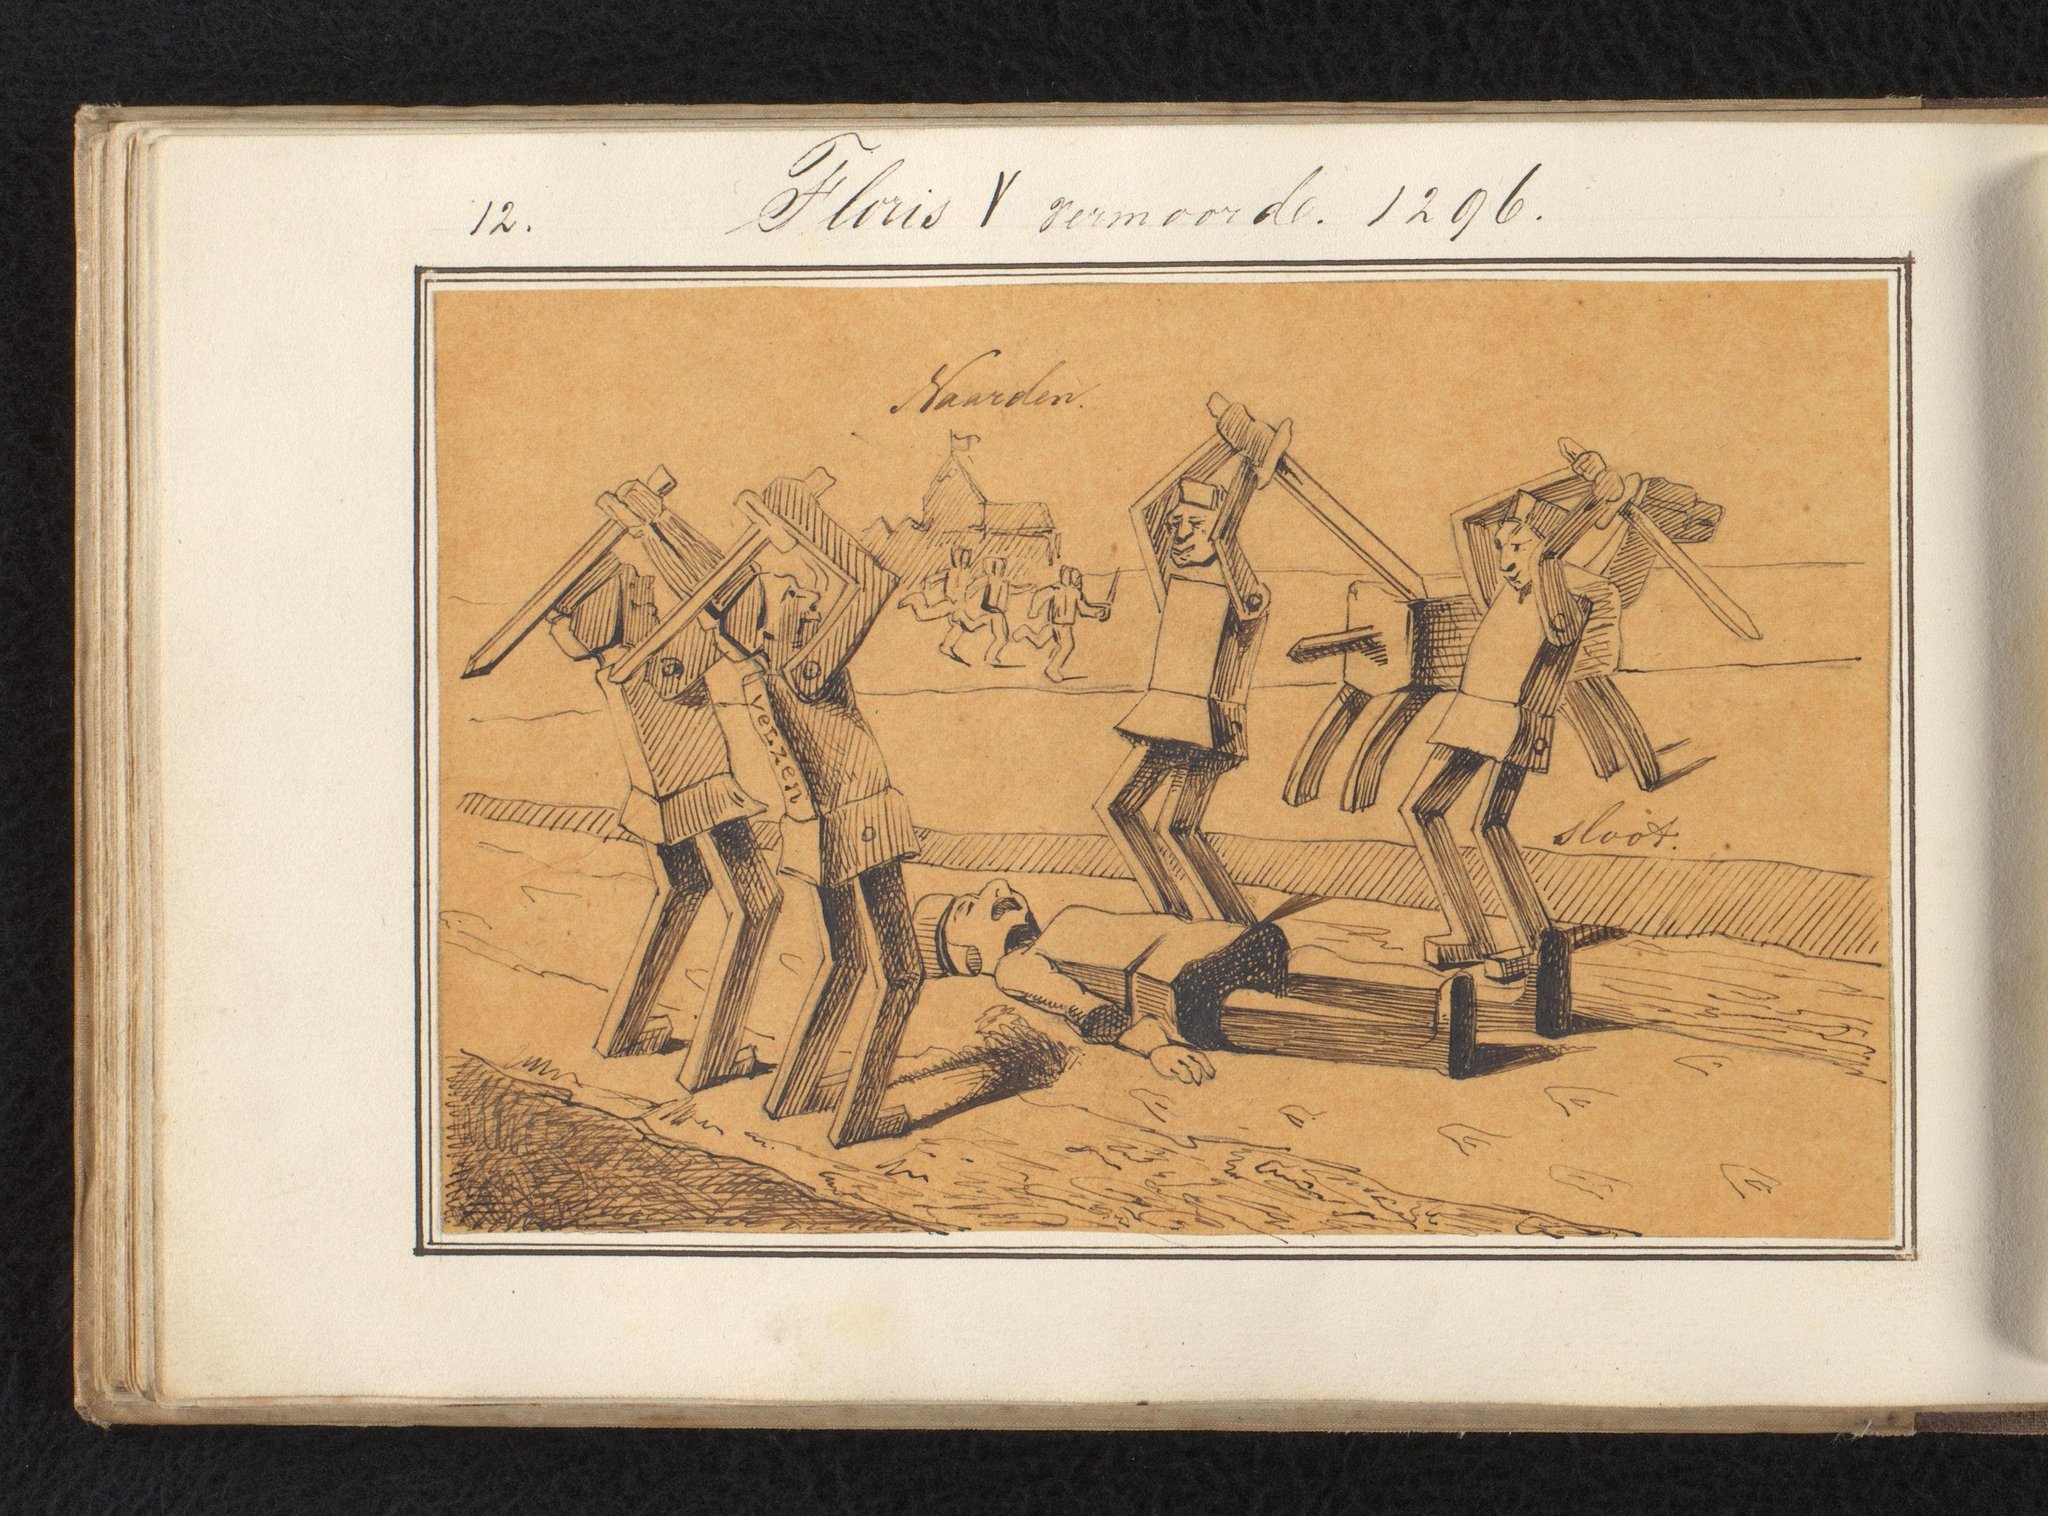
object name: album leaf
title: Floris V, graaf van Holland, vermoord door Gerard van Velsen en anderen, 1296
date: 1853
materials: ink, pencil, paper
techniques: pen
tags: leiden, floris v (graaf van holland en zeeland), city-view, and landscape with man-made constructions, hacking and thrusting weapons: sword, murder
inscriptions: inscription: ‘Naarden’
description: Ontwerp voor: Lennep, Jacob van. Tafereelen uit de geschiedenis des vaderlands, tot nut van groot en klein. Amsterdam: M.H. Binger en Zonen, 1854.